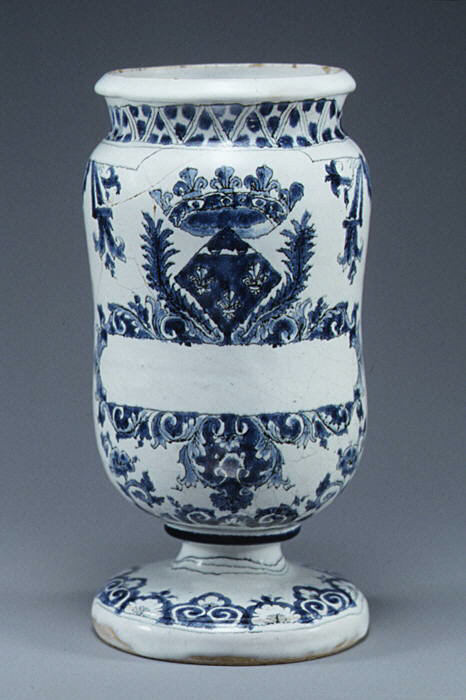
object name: pharmacy jar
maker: dubois manufactory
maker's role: maker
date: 1722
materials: faience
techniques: glazing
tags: coat of arms,crowns